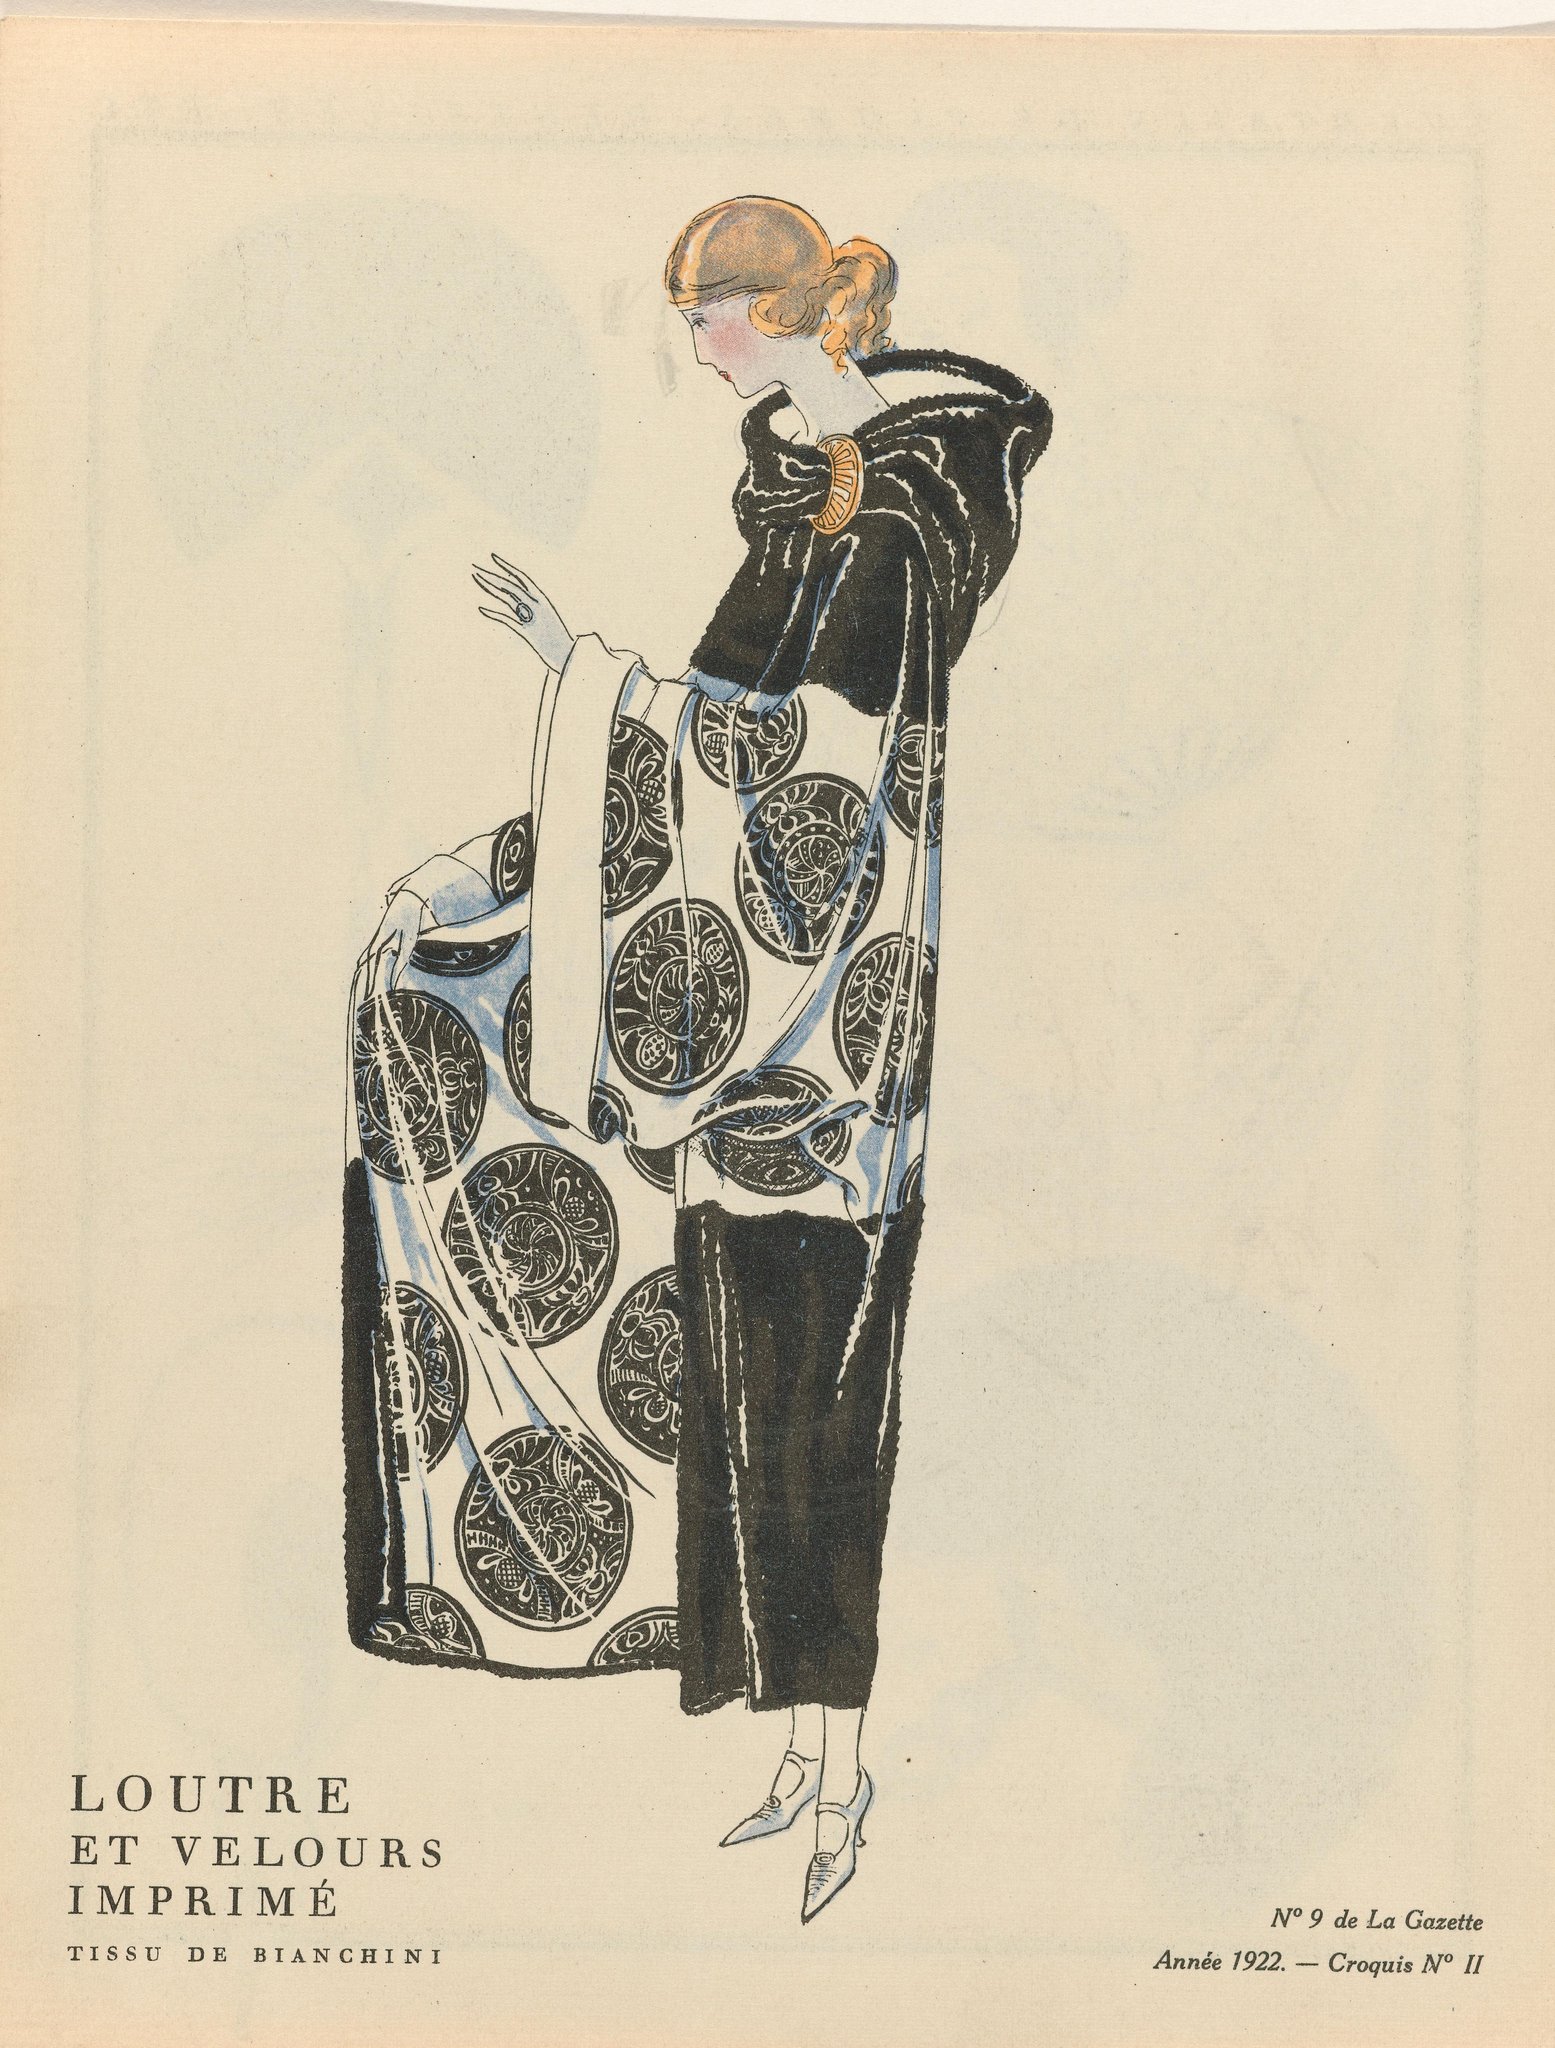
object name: fashion print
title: Gazette du Bon Ton, 1922 - No. 9 : Loutre et velours imprimé / Tissu de Bianchini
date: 1922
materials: paper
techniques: printing, letterpress printing, photochemical processes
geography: new york city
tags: ring (+ women's clothes), coat (evening coat) (+ women's clothes), fashion plates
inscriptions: date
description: Fluwelen avondmantel met bont van Bianchini. Croquis No II uit Gazette du Bon Ton 1922, No. 9. Uitleg over de kleding op pagina "Recto des pages de croquis. Contenues dans ce fascicule (Modèles de la gazette)."